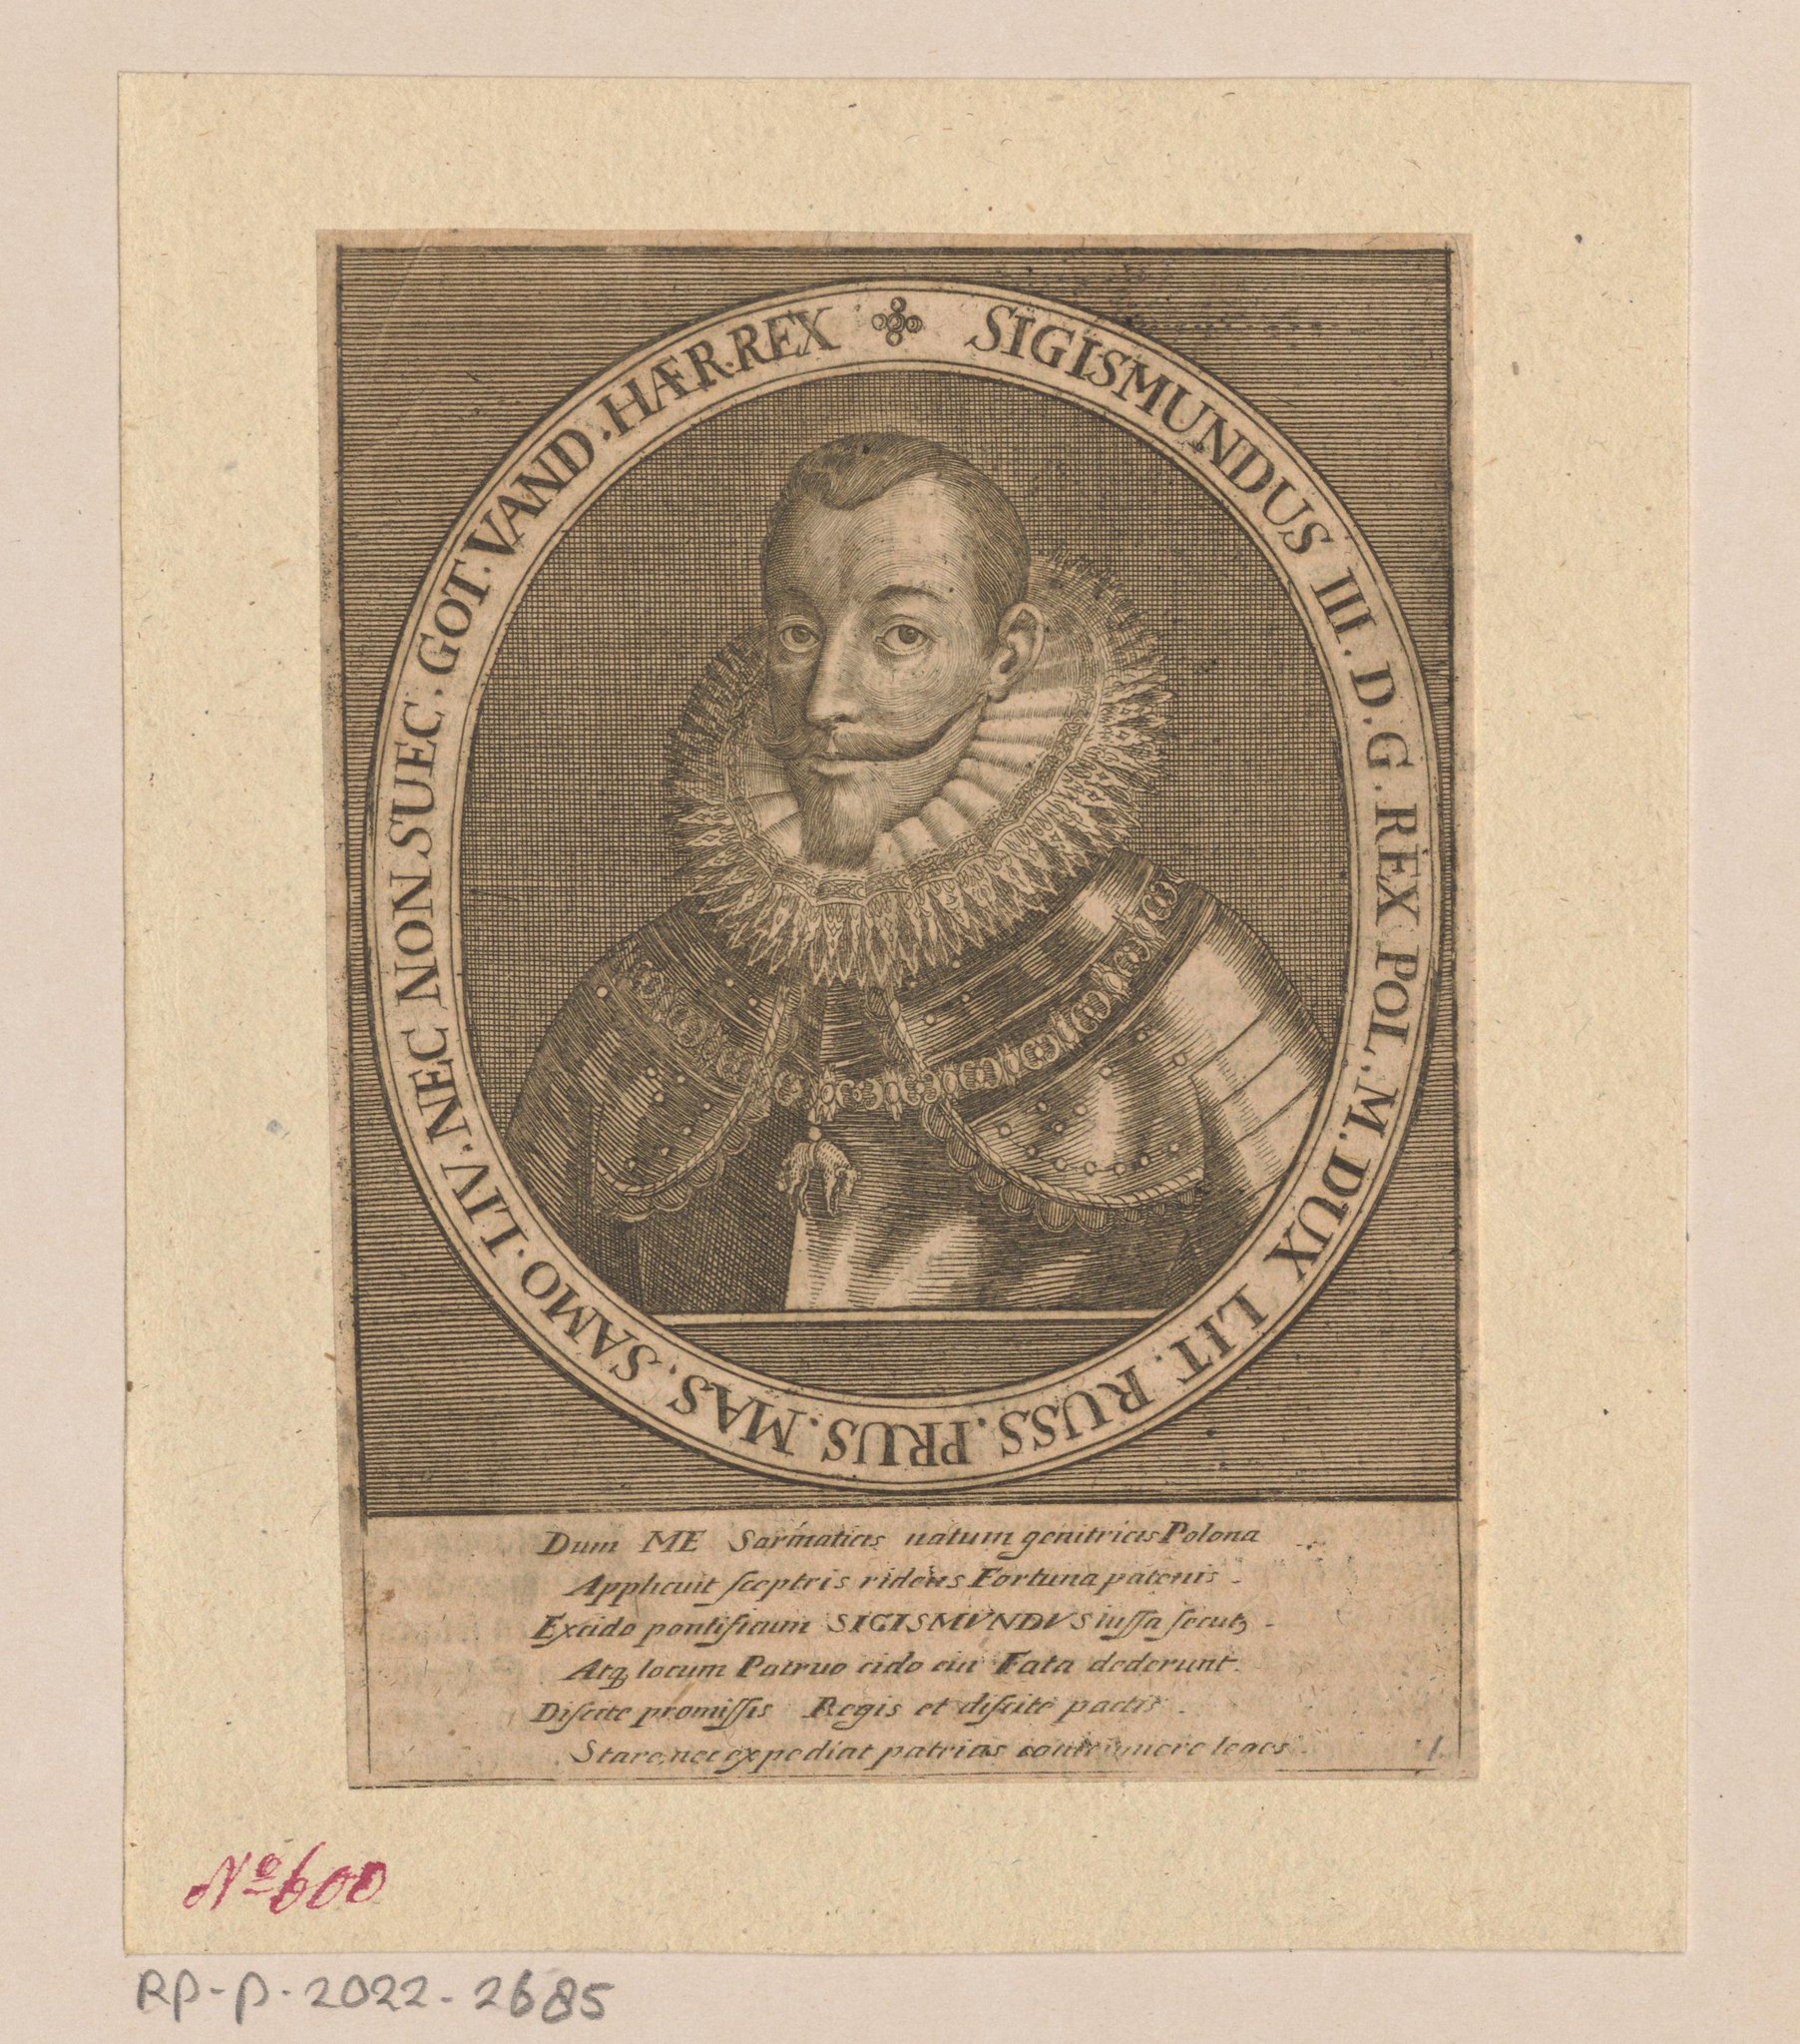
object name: book illustration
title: Portret van Sigismund III van Polen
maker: Anonymous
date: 1600-1699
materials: paper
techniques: engraving, etching, letterpress printing, snipping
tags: sigismund iii (koning van polen), historical persons, knighthood order of the golden fleece - insignia of a knighthood order, e.g.: badge, chain (with name of order), king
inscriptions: inscription: ‘M[...] 237 / 29 / 43 / 34 / XXI / 343’, number: ‘No 600’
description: Met zesregelig onderschrift in het Latijn en tekst in het Latijn rondom het portret.